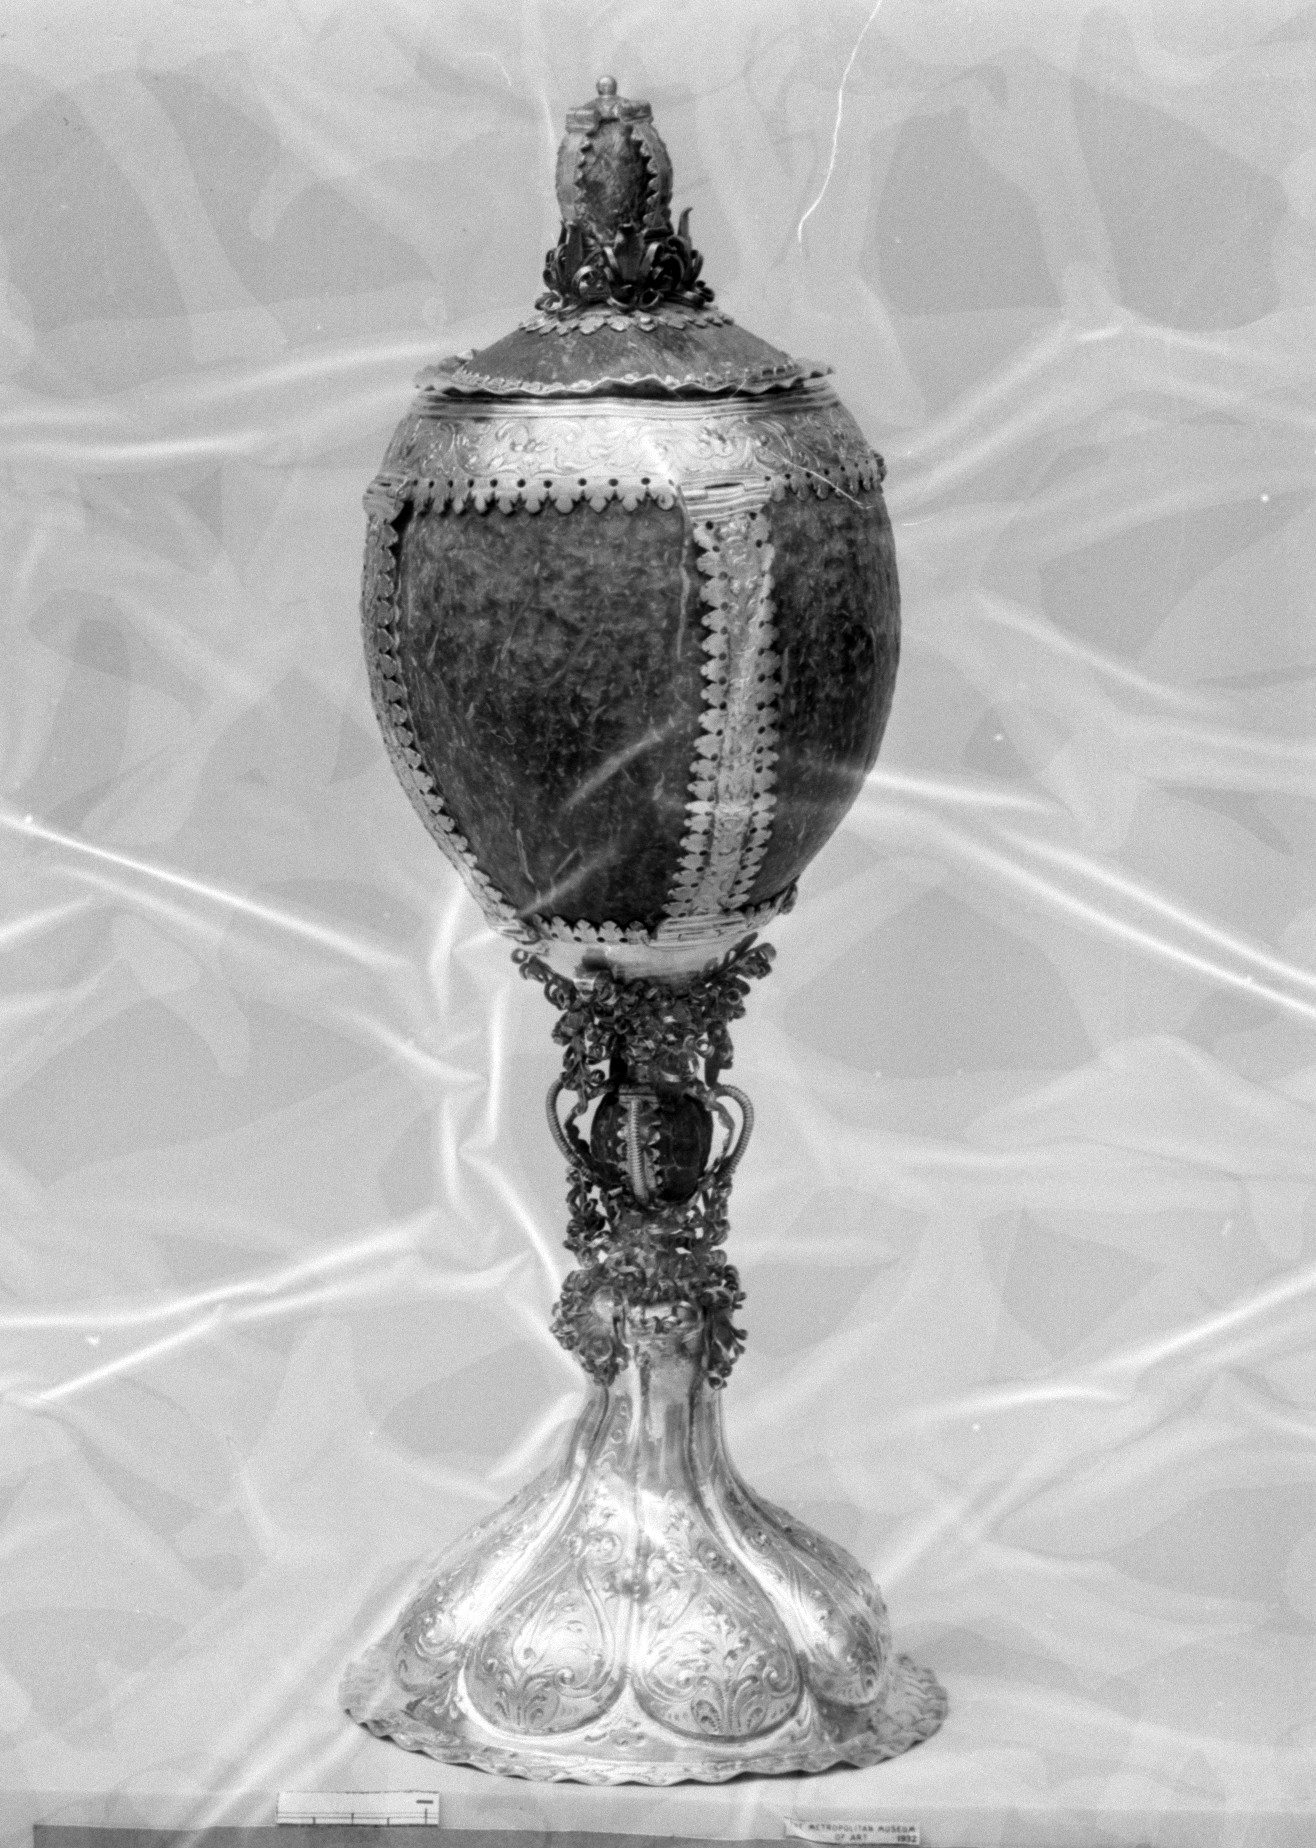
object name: cup with cover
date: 1801-1900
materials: silver gilt